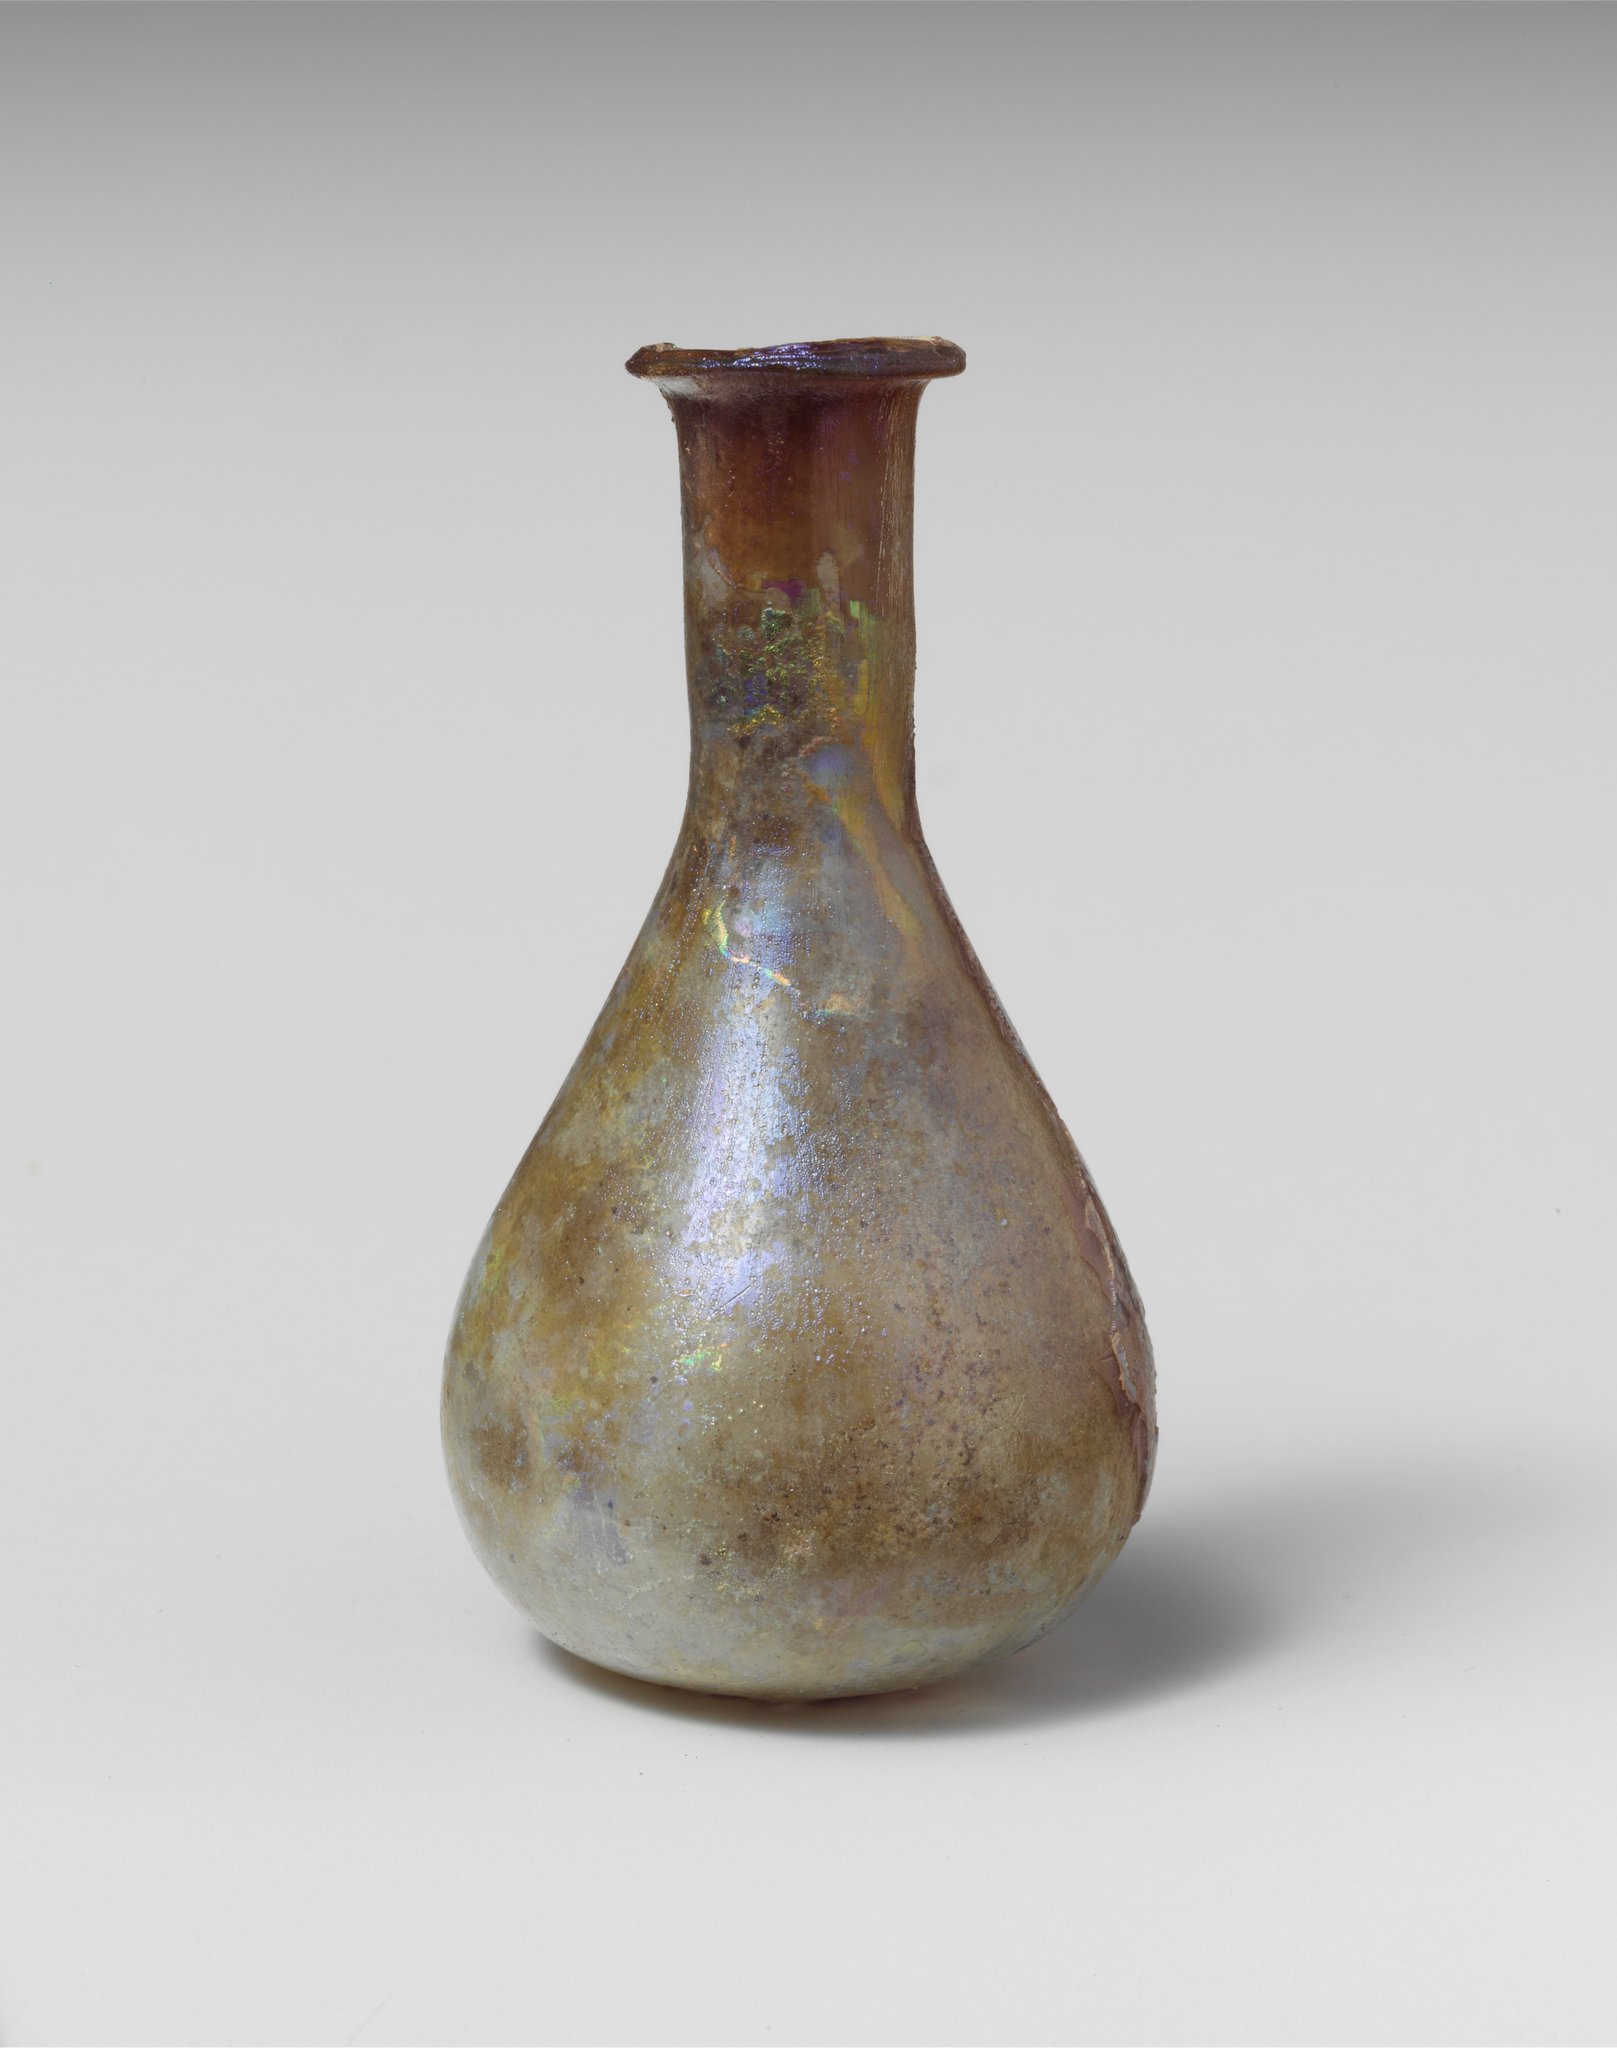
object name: perfume bottle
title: Glass perfume bottle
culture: roman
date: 1-100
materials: glass